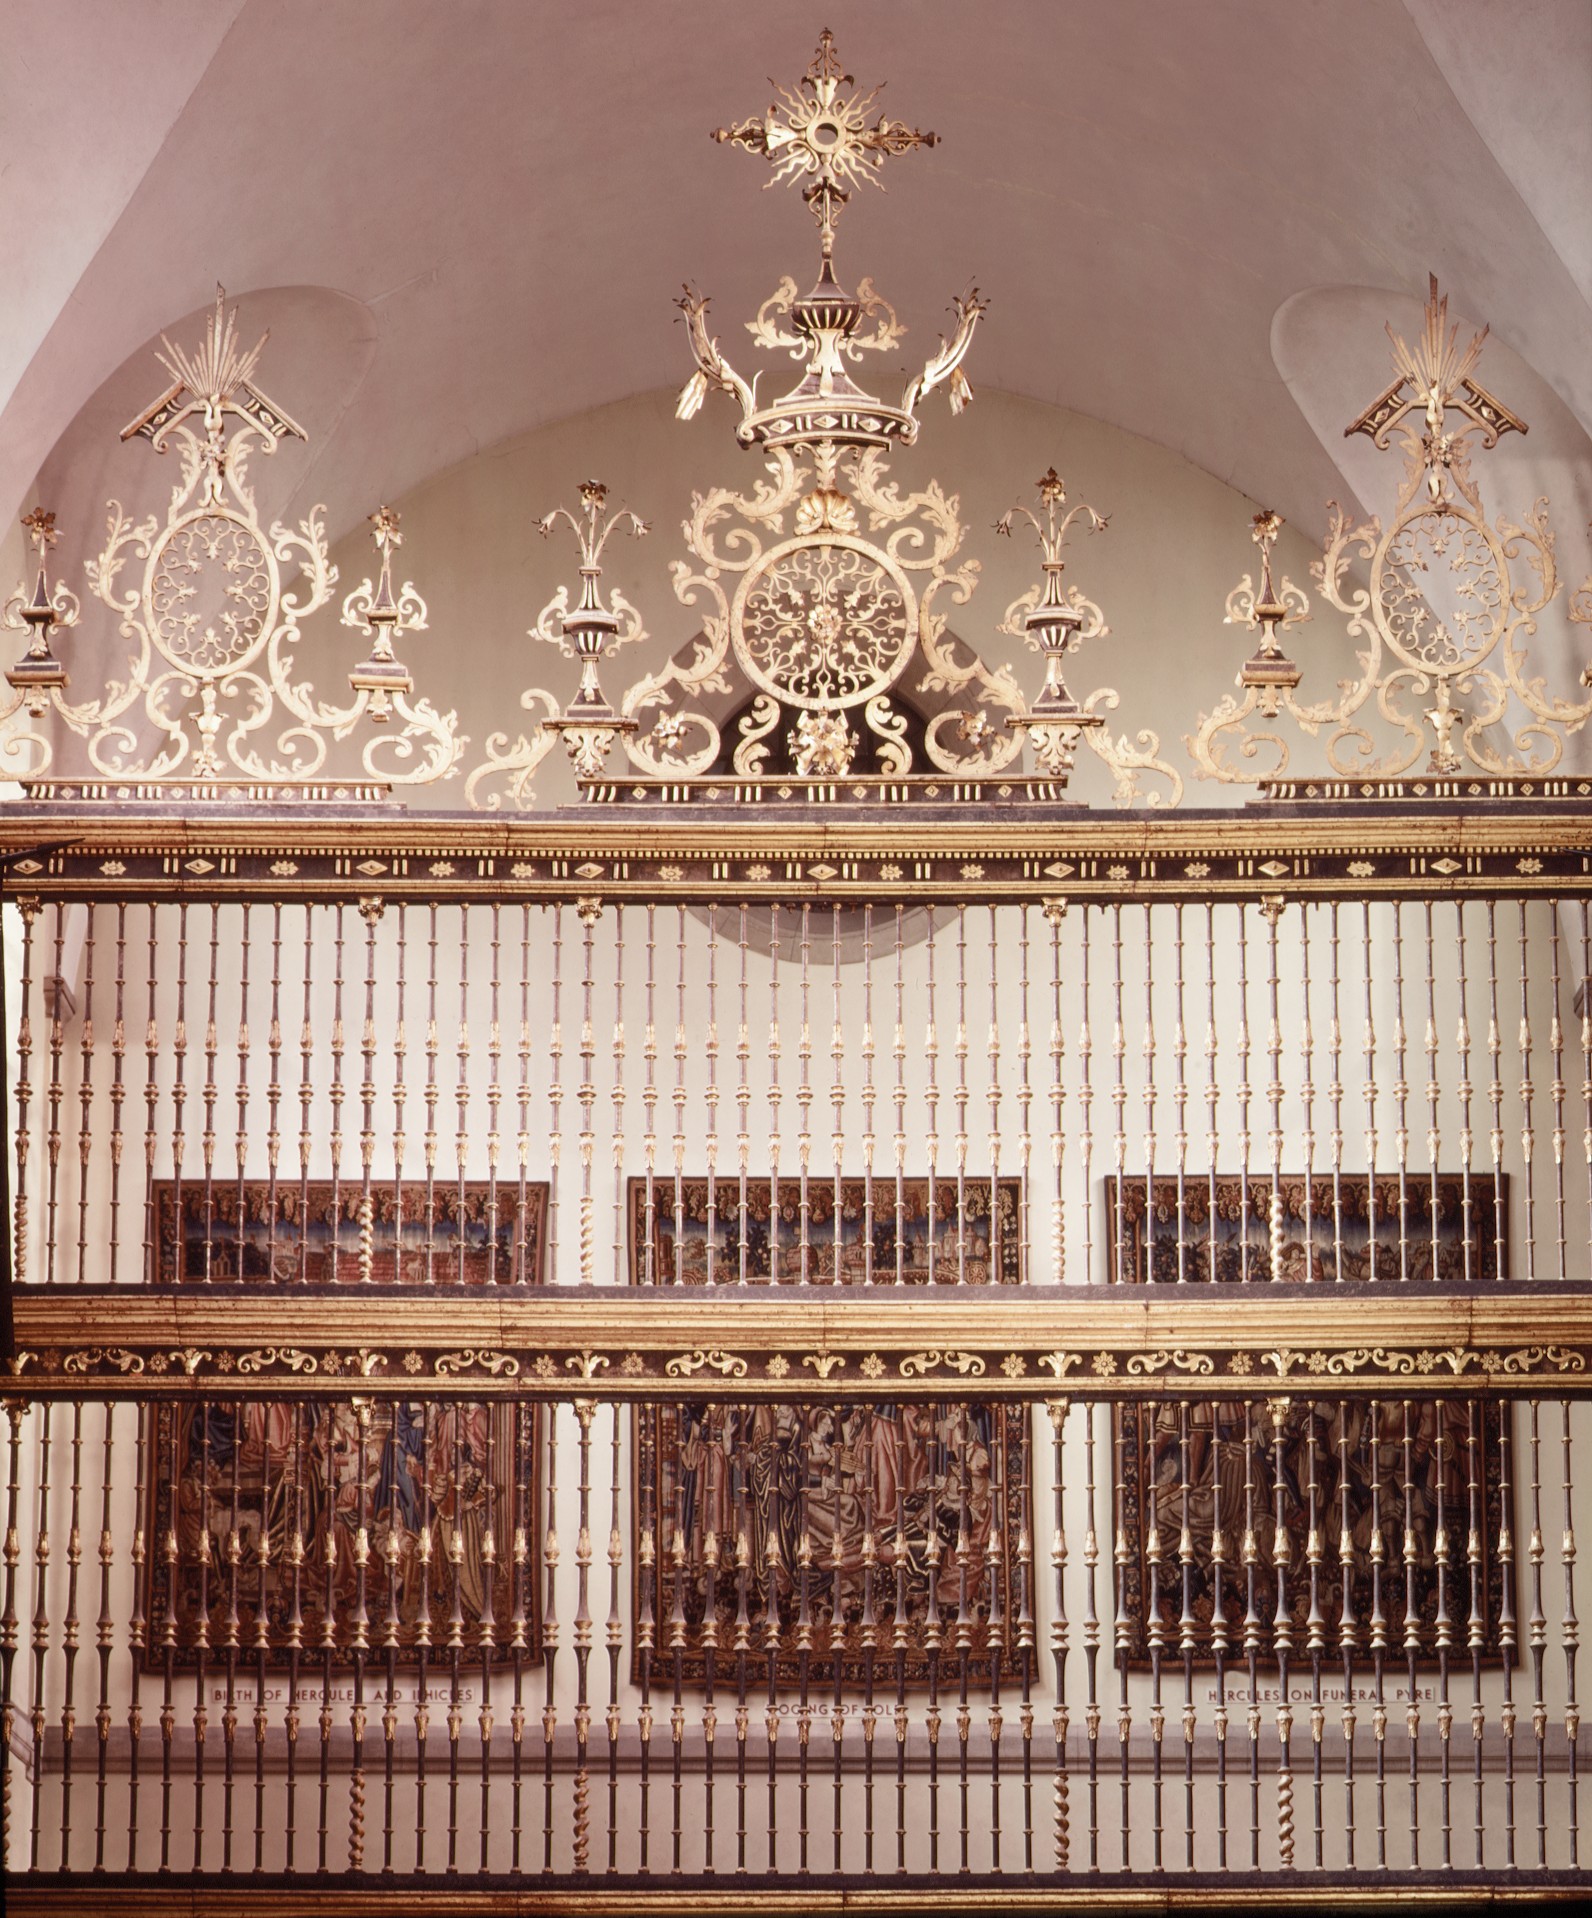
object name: choir screen panel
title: Choir screen from the Cathedral of Valladolid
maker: rafal amezúa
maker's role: maker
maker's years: 1725-1825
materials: iron, limestone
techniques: gilding, painting